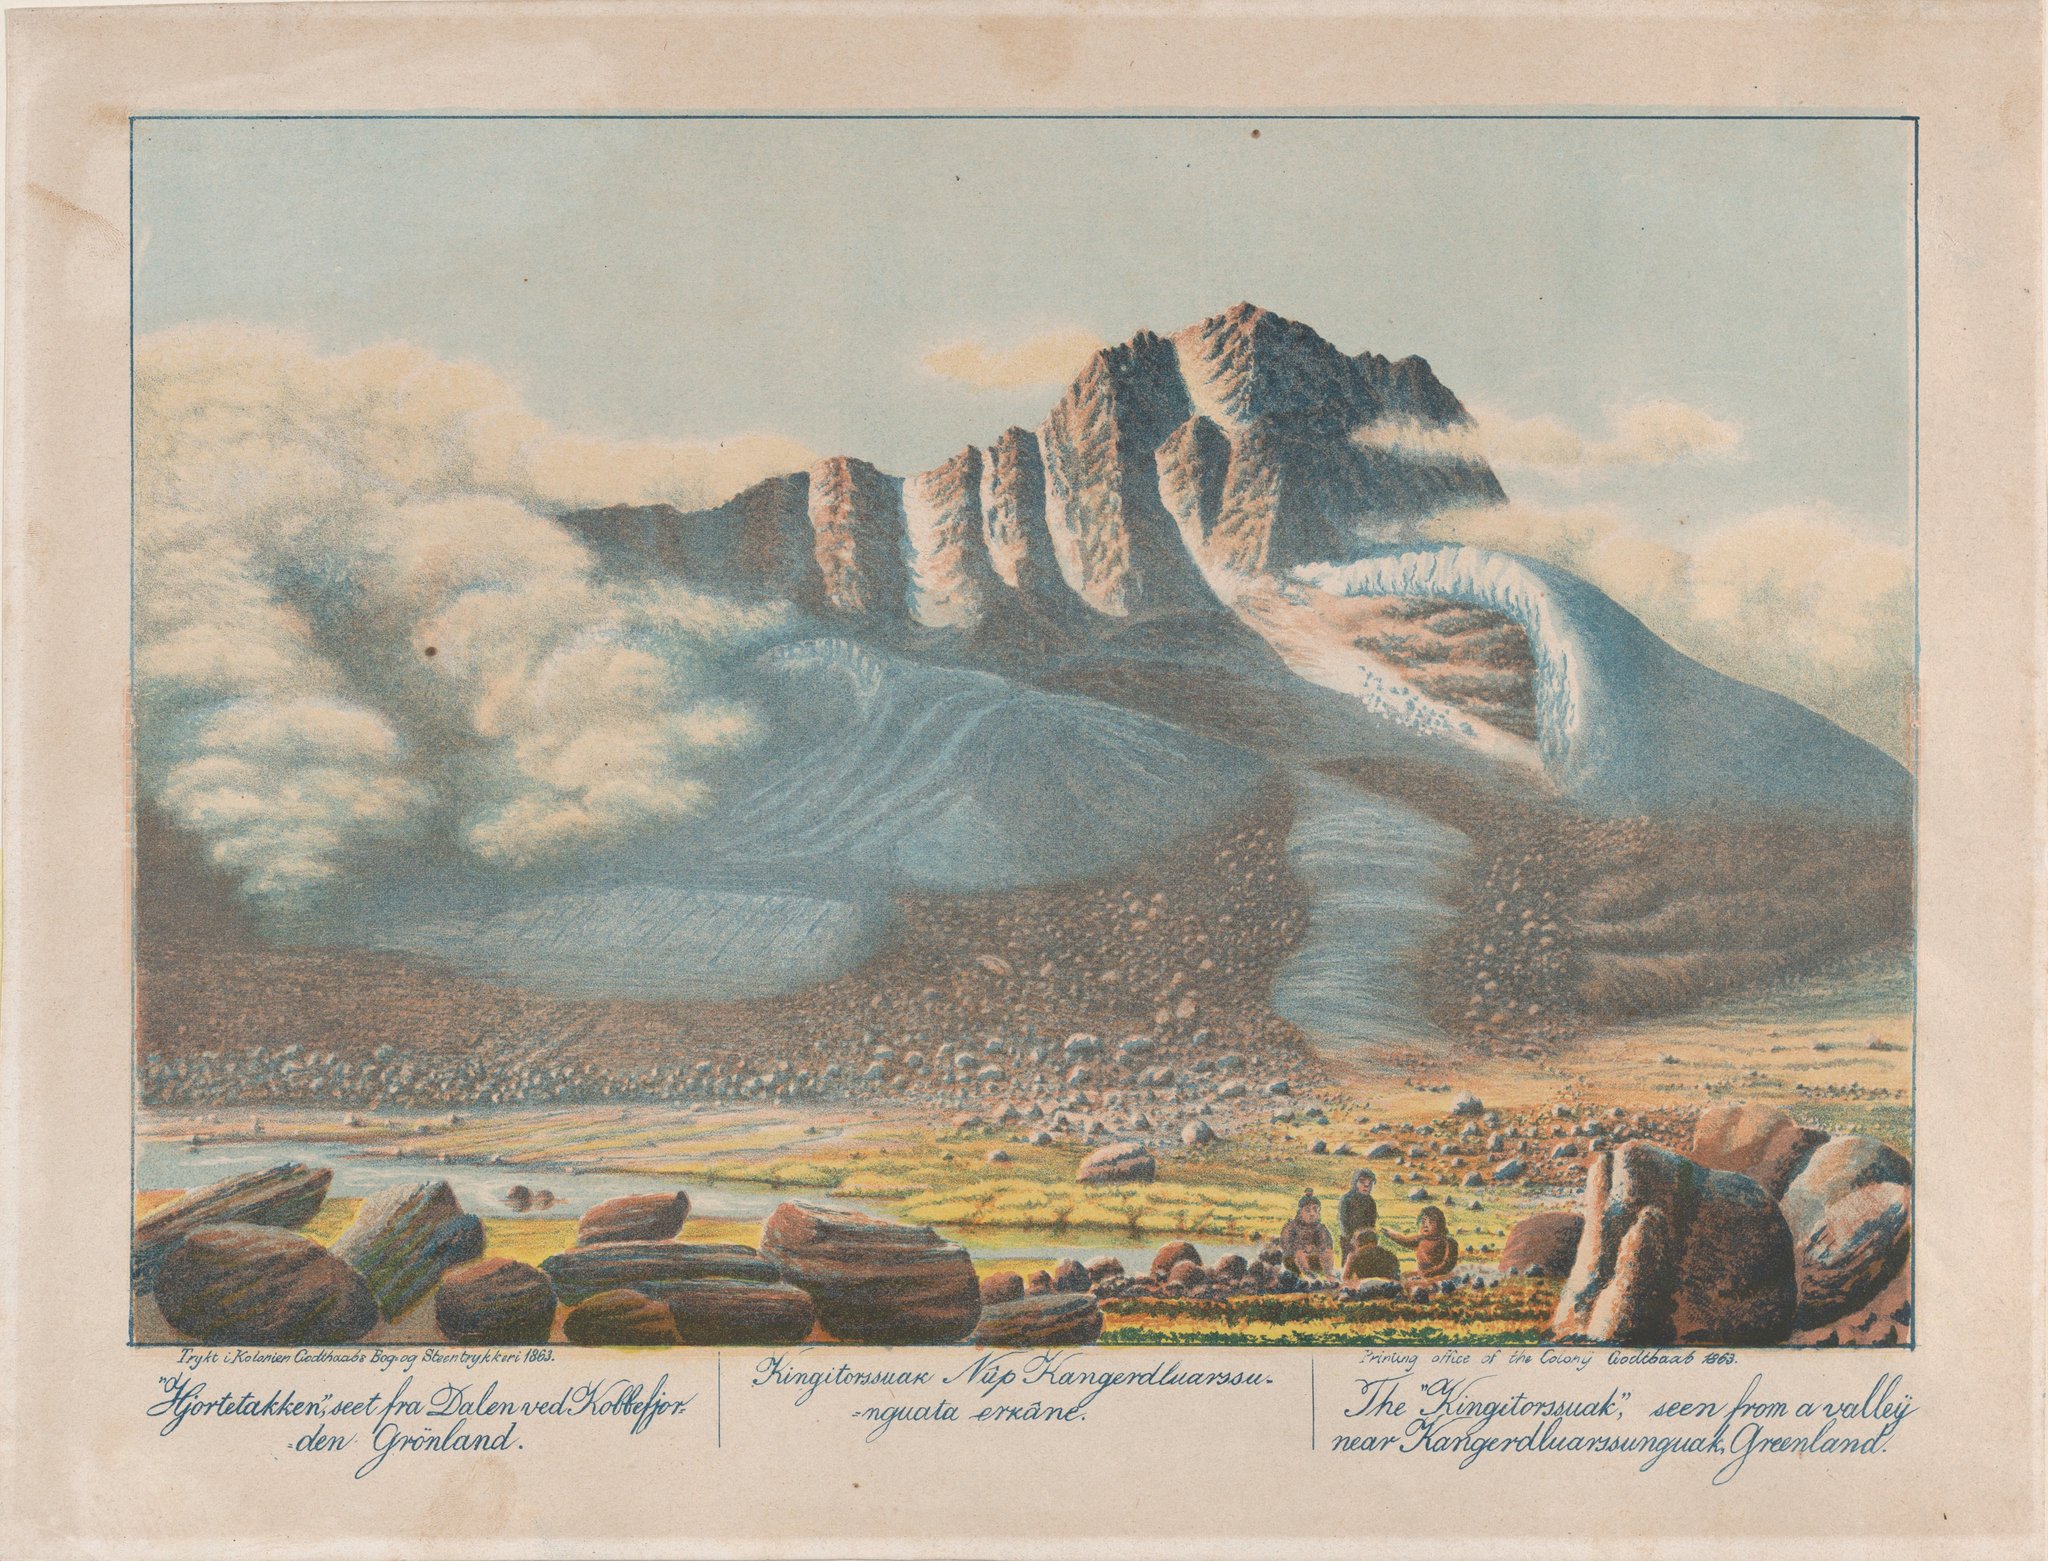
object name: print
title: The "Kingitorssuak" seen from a valley near Kangerdluarssunguak, Greenland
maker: lars møller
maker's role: artist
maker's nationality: greenlandic-inuit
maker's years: 1842-1926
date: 1863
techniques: lithograph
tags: hills,landscapes